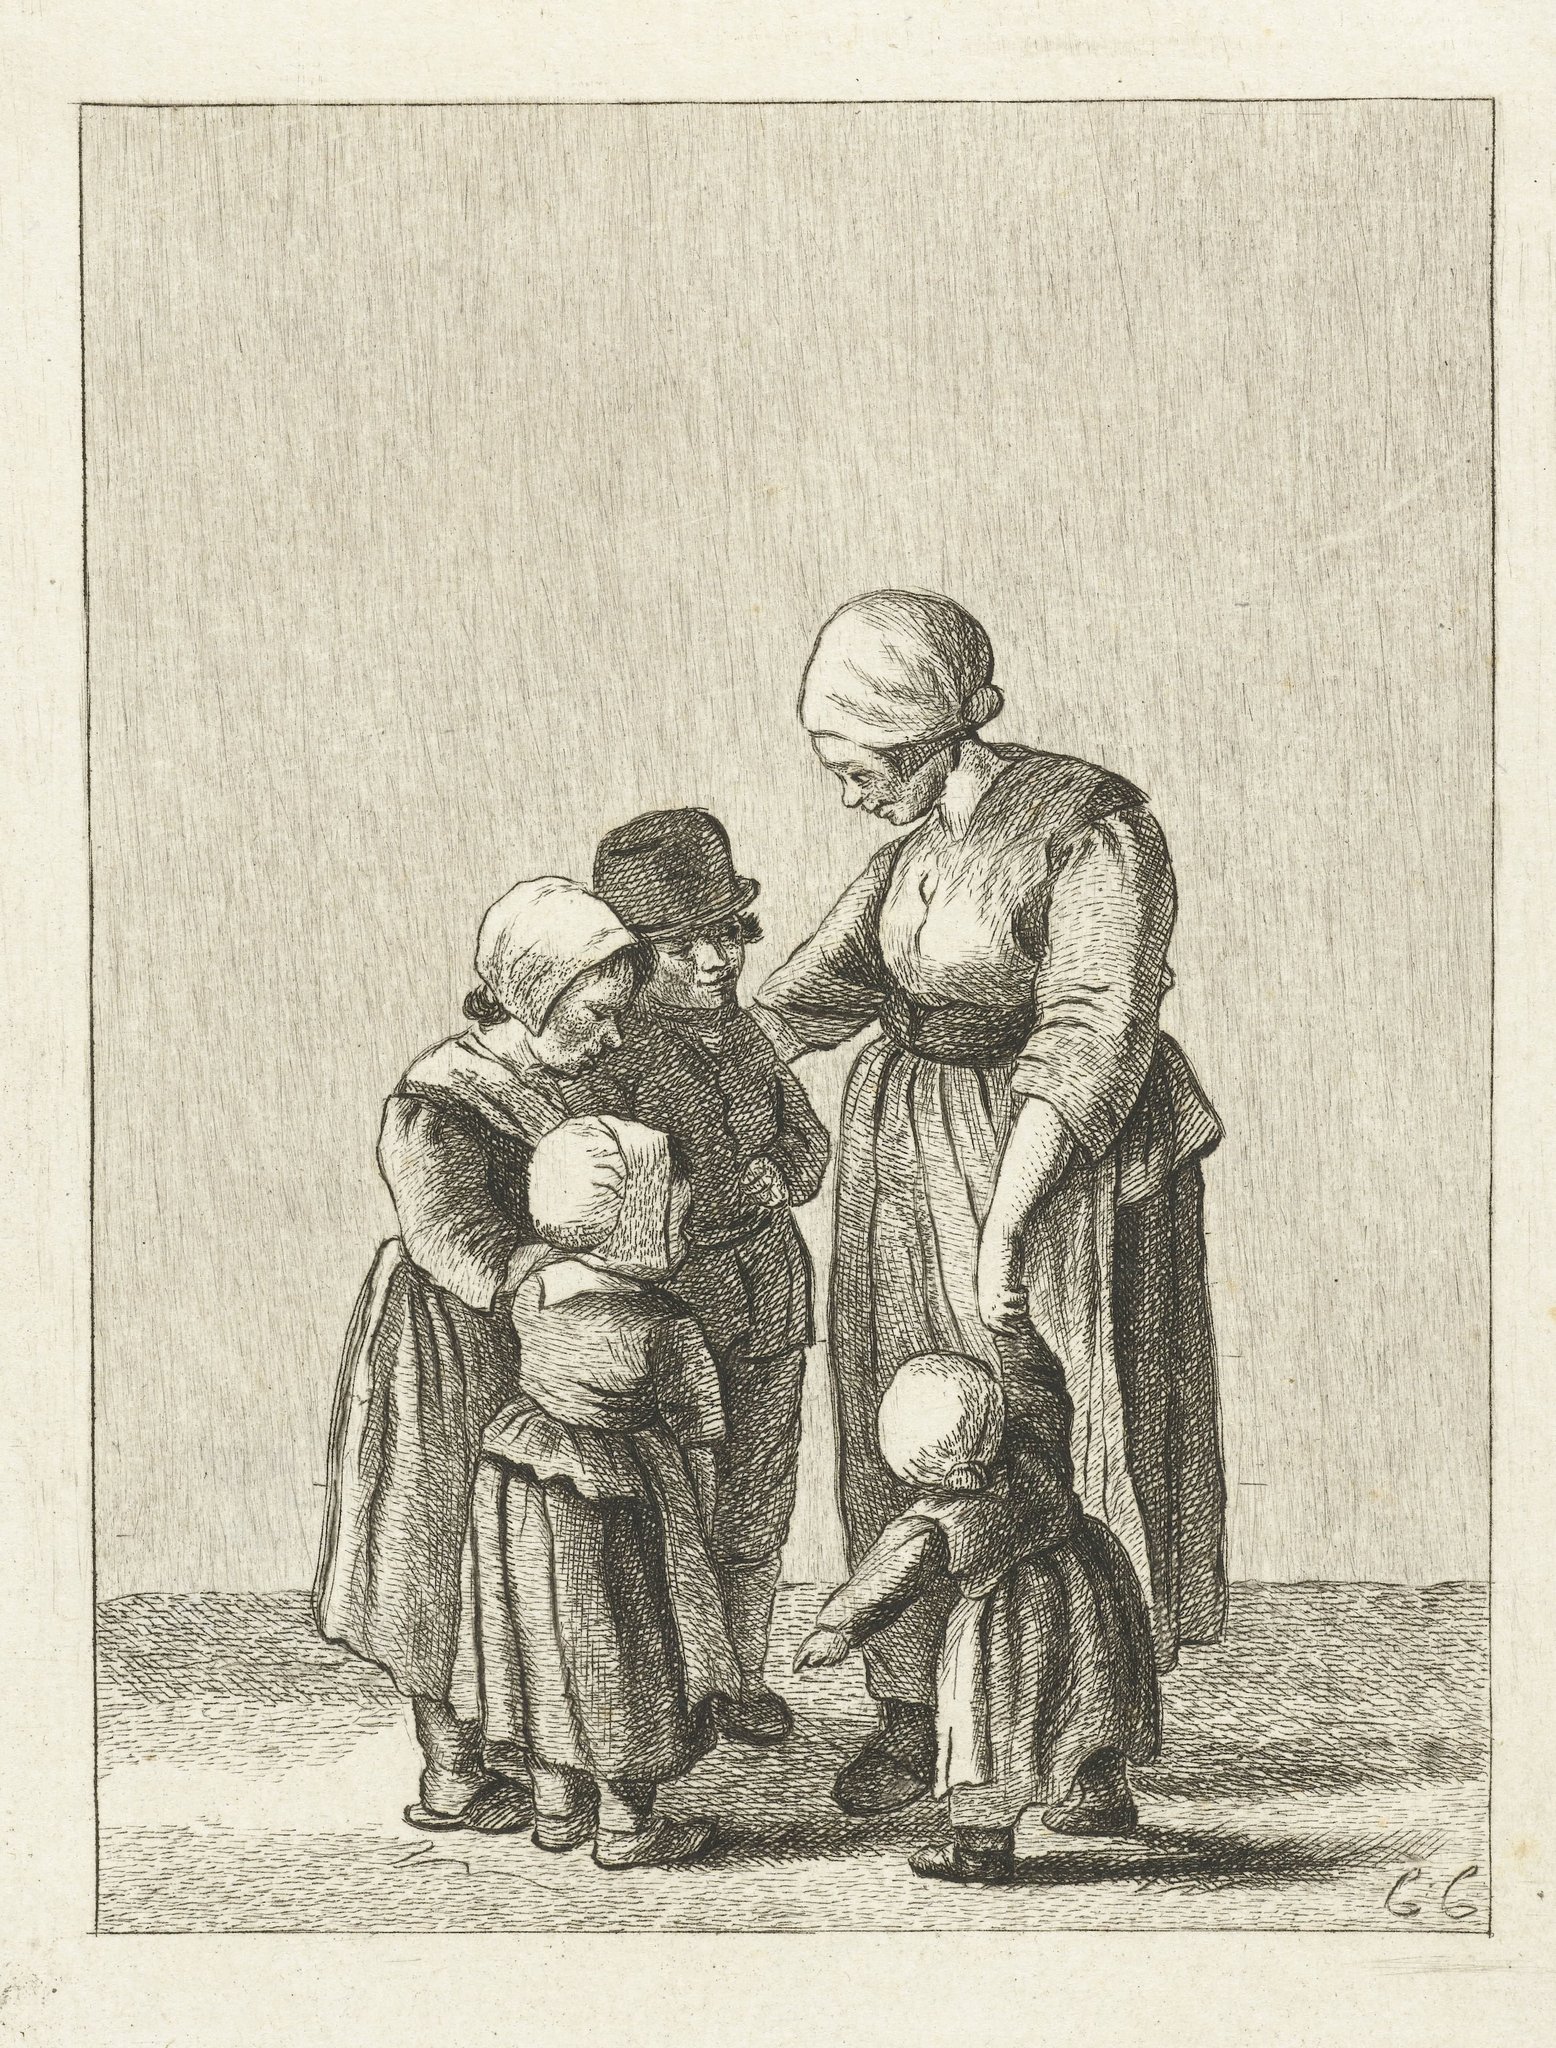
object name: print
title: Moeder met vier kinderen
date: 1779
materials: paper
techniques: etching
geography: leiden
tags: mother and baby or young child, brothers or sisters (second degree family relationships)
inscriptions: collector's mark: Lugt 2233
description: Een moeder met vier kinderen. De jongste houdt ze bij de hand.